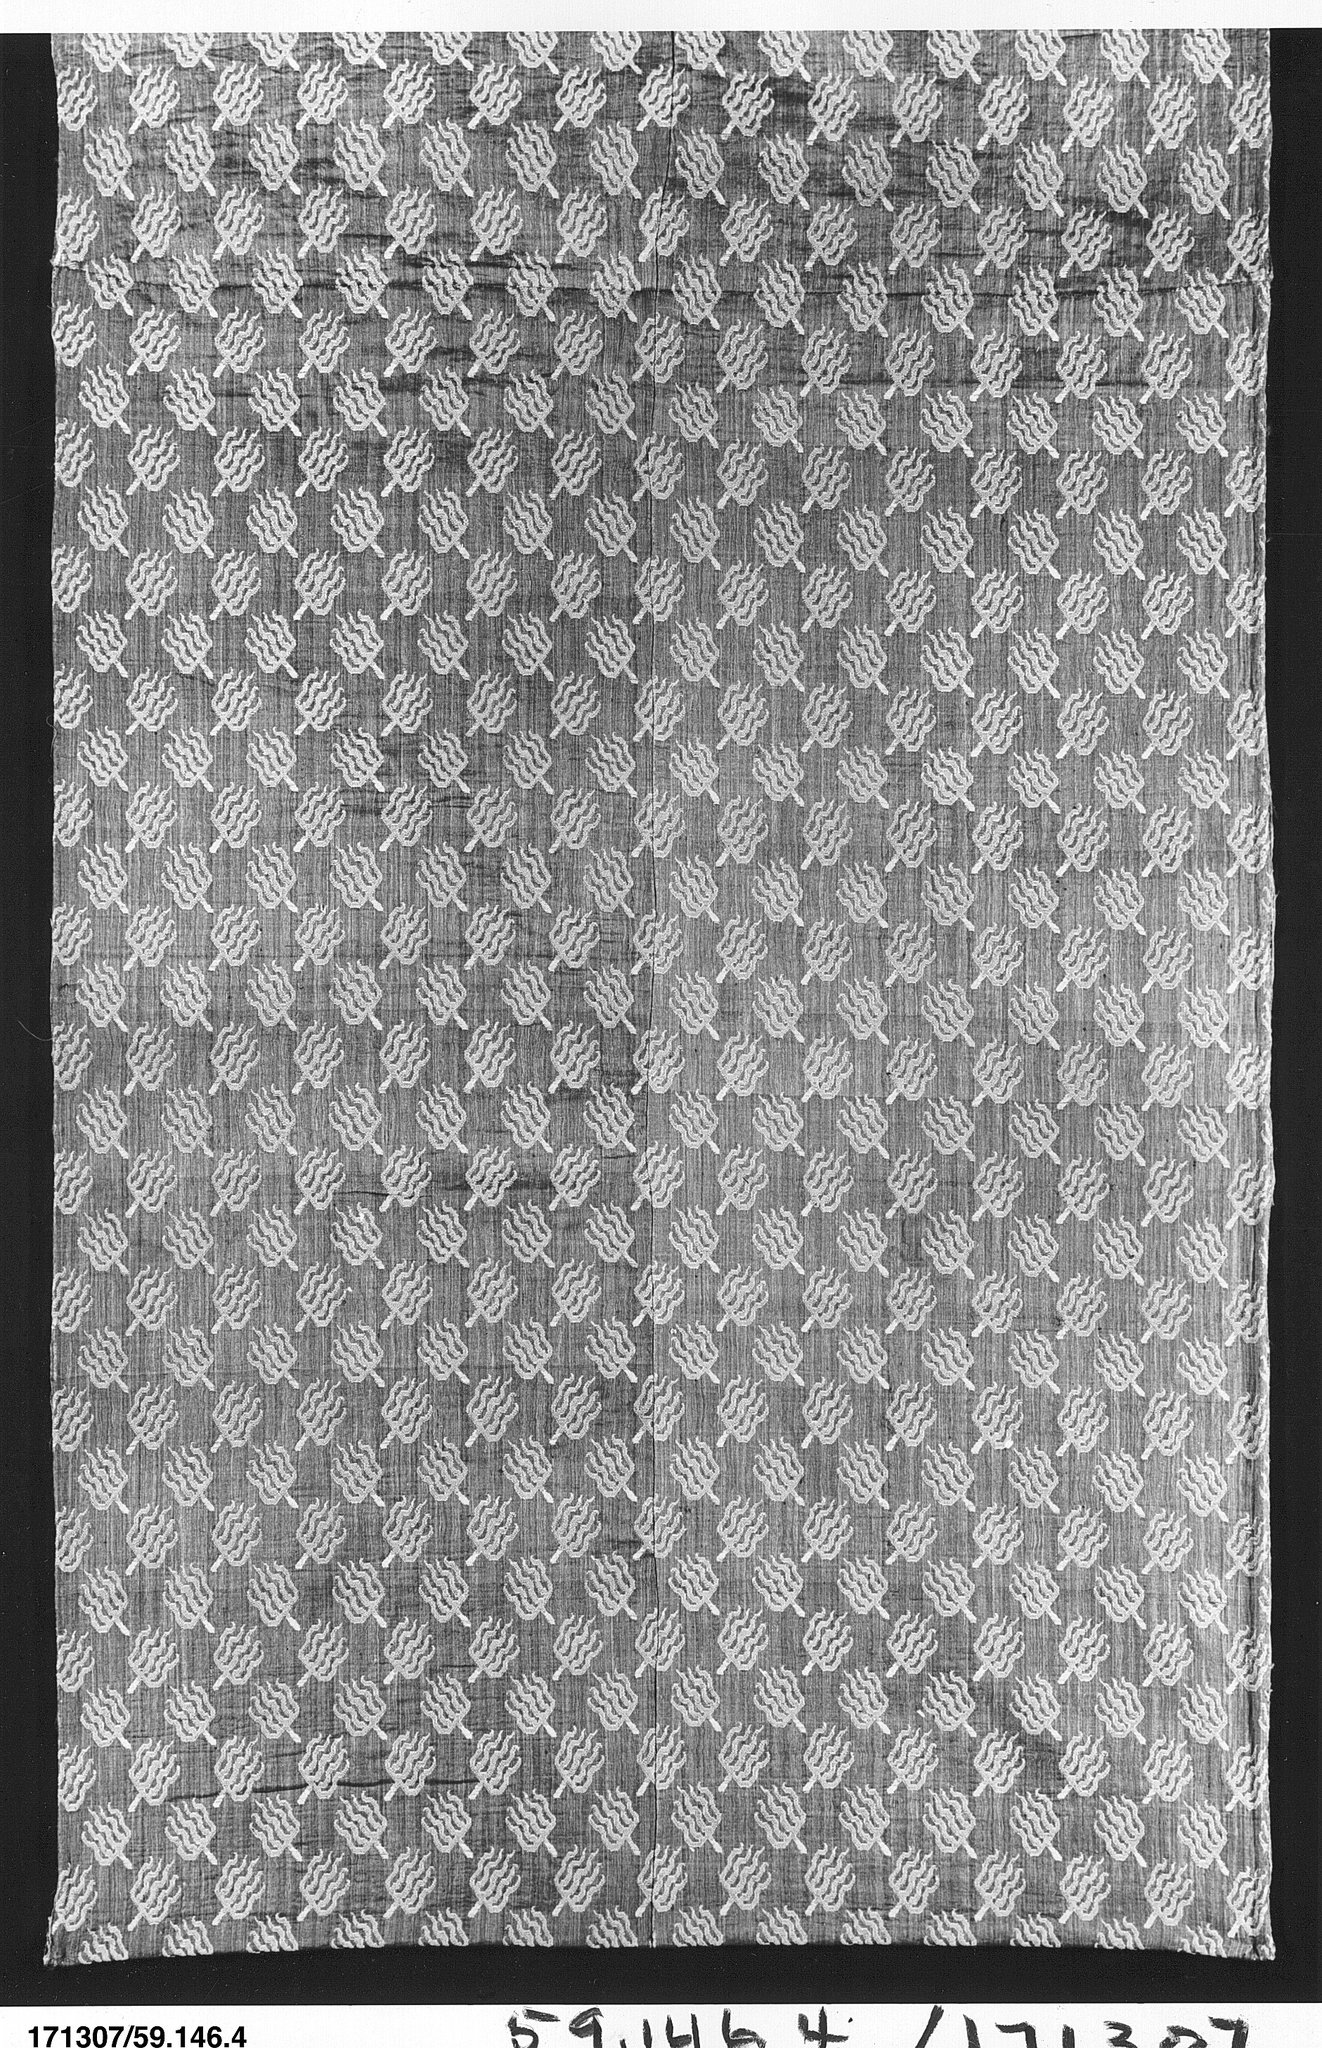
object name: piece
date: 1501-1700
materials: cotton, silk